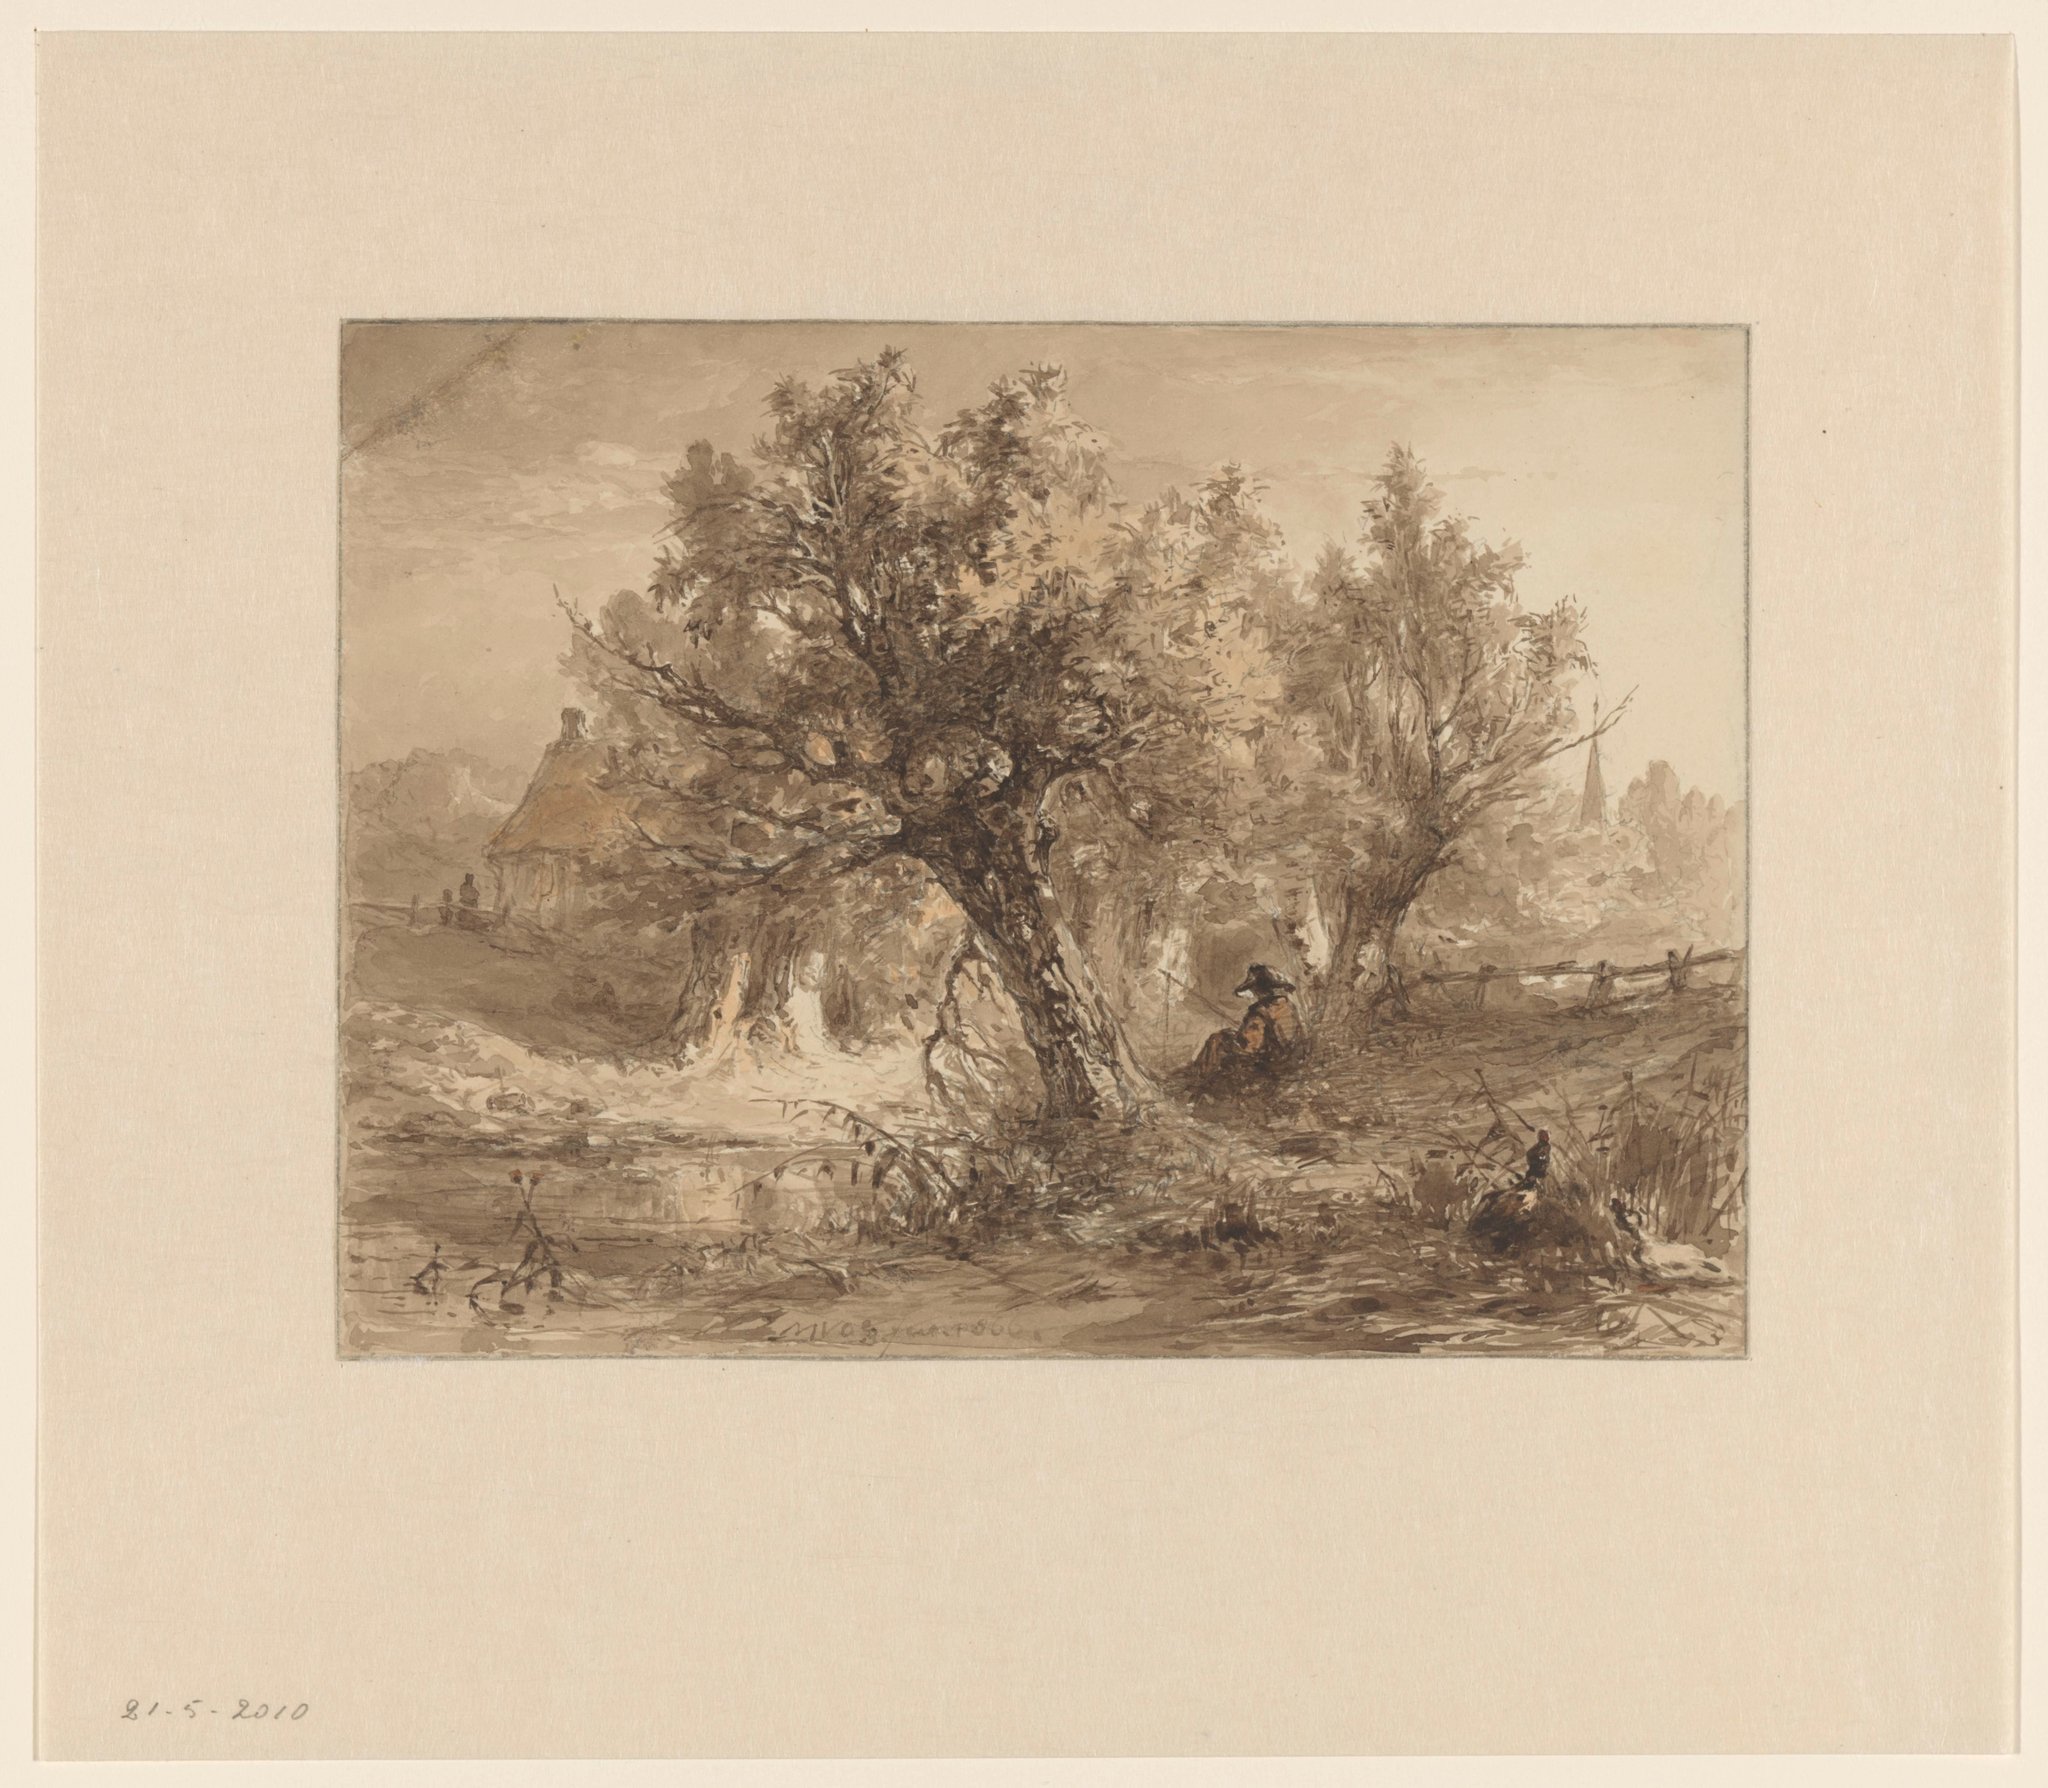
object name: watercolor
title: Landschap met hengelaar onder wilgen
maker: maria vos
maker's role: draughtsman, painter, print maker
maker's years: 1824-1906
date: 1866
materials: paper, pencil, watercolor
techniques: brush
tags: small canal, ditch, farm or solitary house in landscape